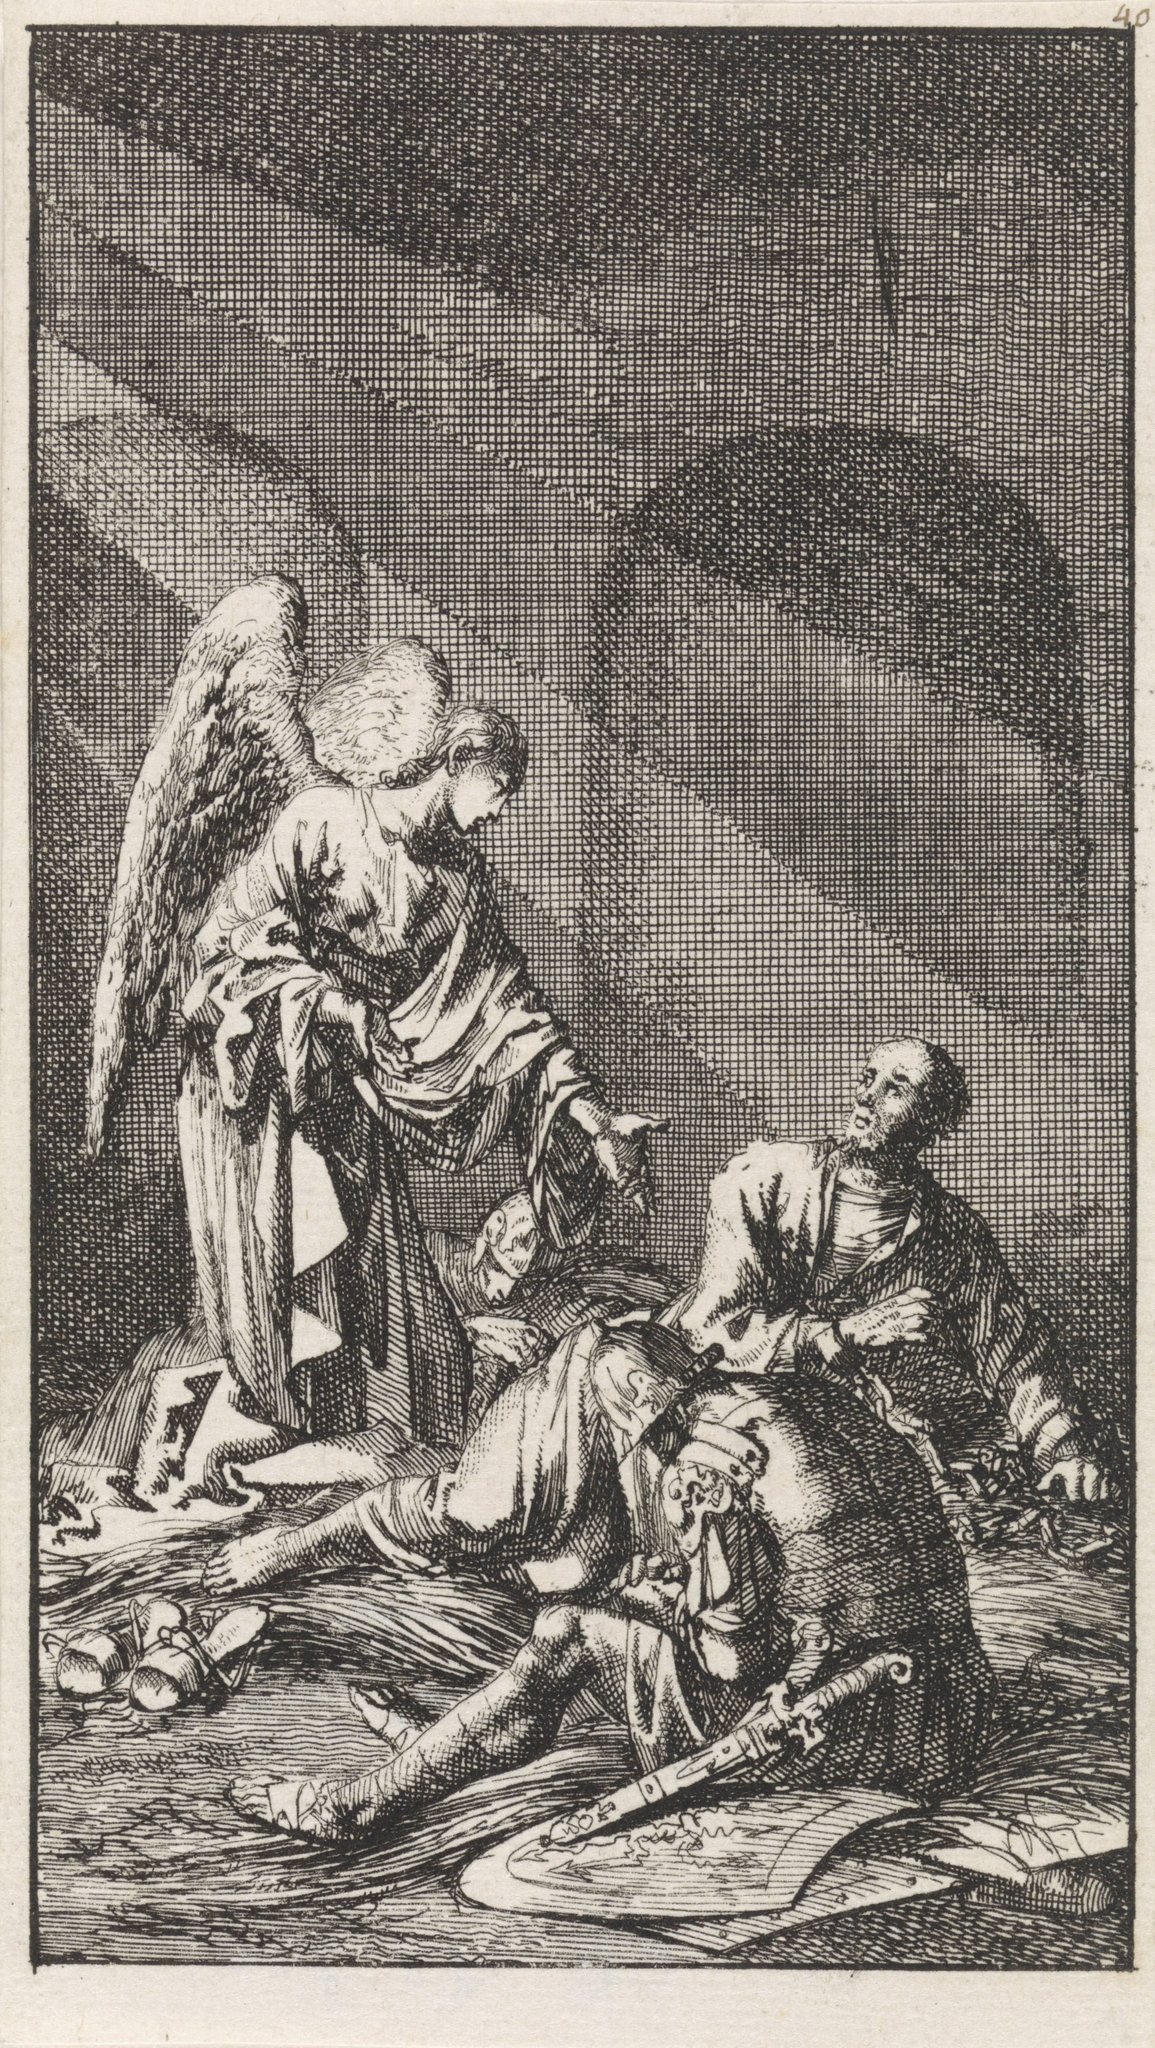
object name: print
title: Bevrijding van Petrus uit de gevangenis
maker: jan luyken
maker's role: draughtsman, print maker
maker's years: 1649-1712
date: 1712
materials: paper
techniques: etching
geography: amsterdam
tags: the angel leads peter past the sleeping guards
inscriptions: collector's mark: Lugt 2228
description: Proefdruk van illustratie voor: Luyken, Jan. Bybel printen. Amsterdam: Pieter Arentsz. II (wed.) en Cornelis van der Sys, 1712, p. 40.